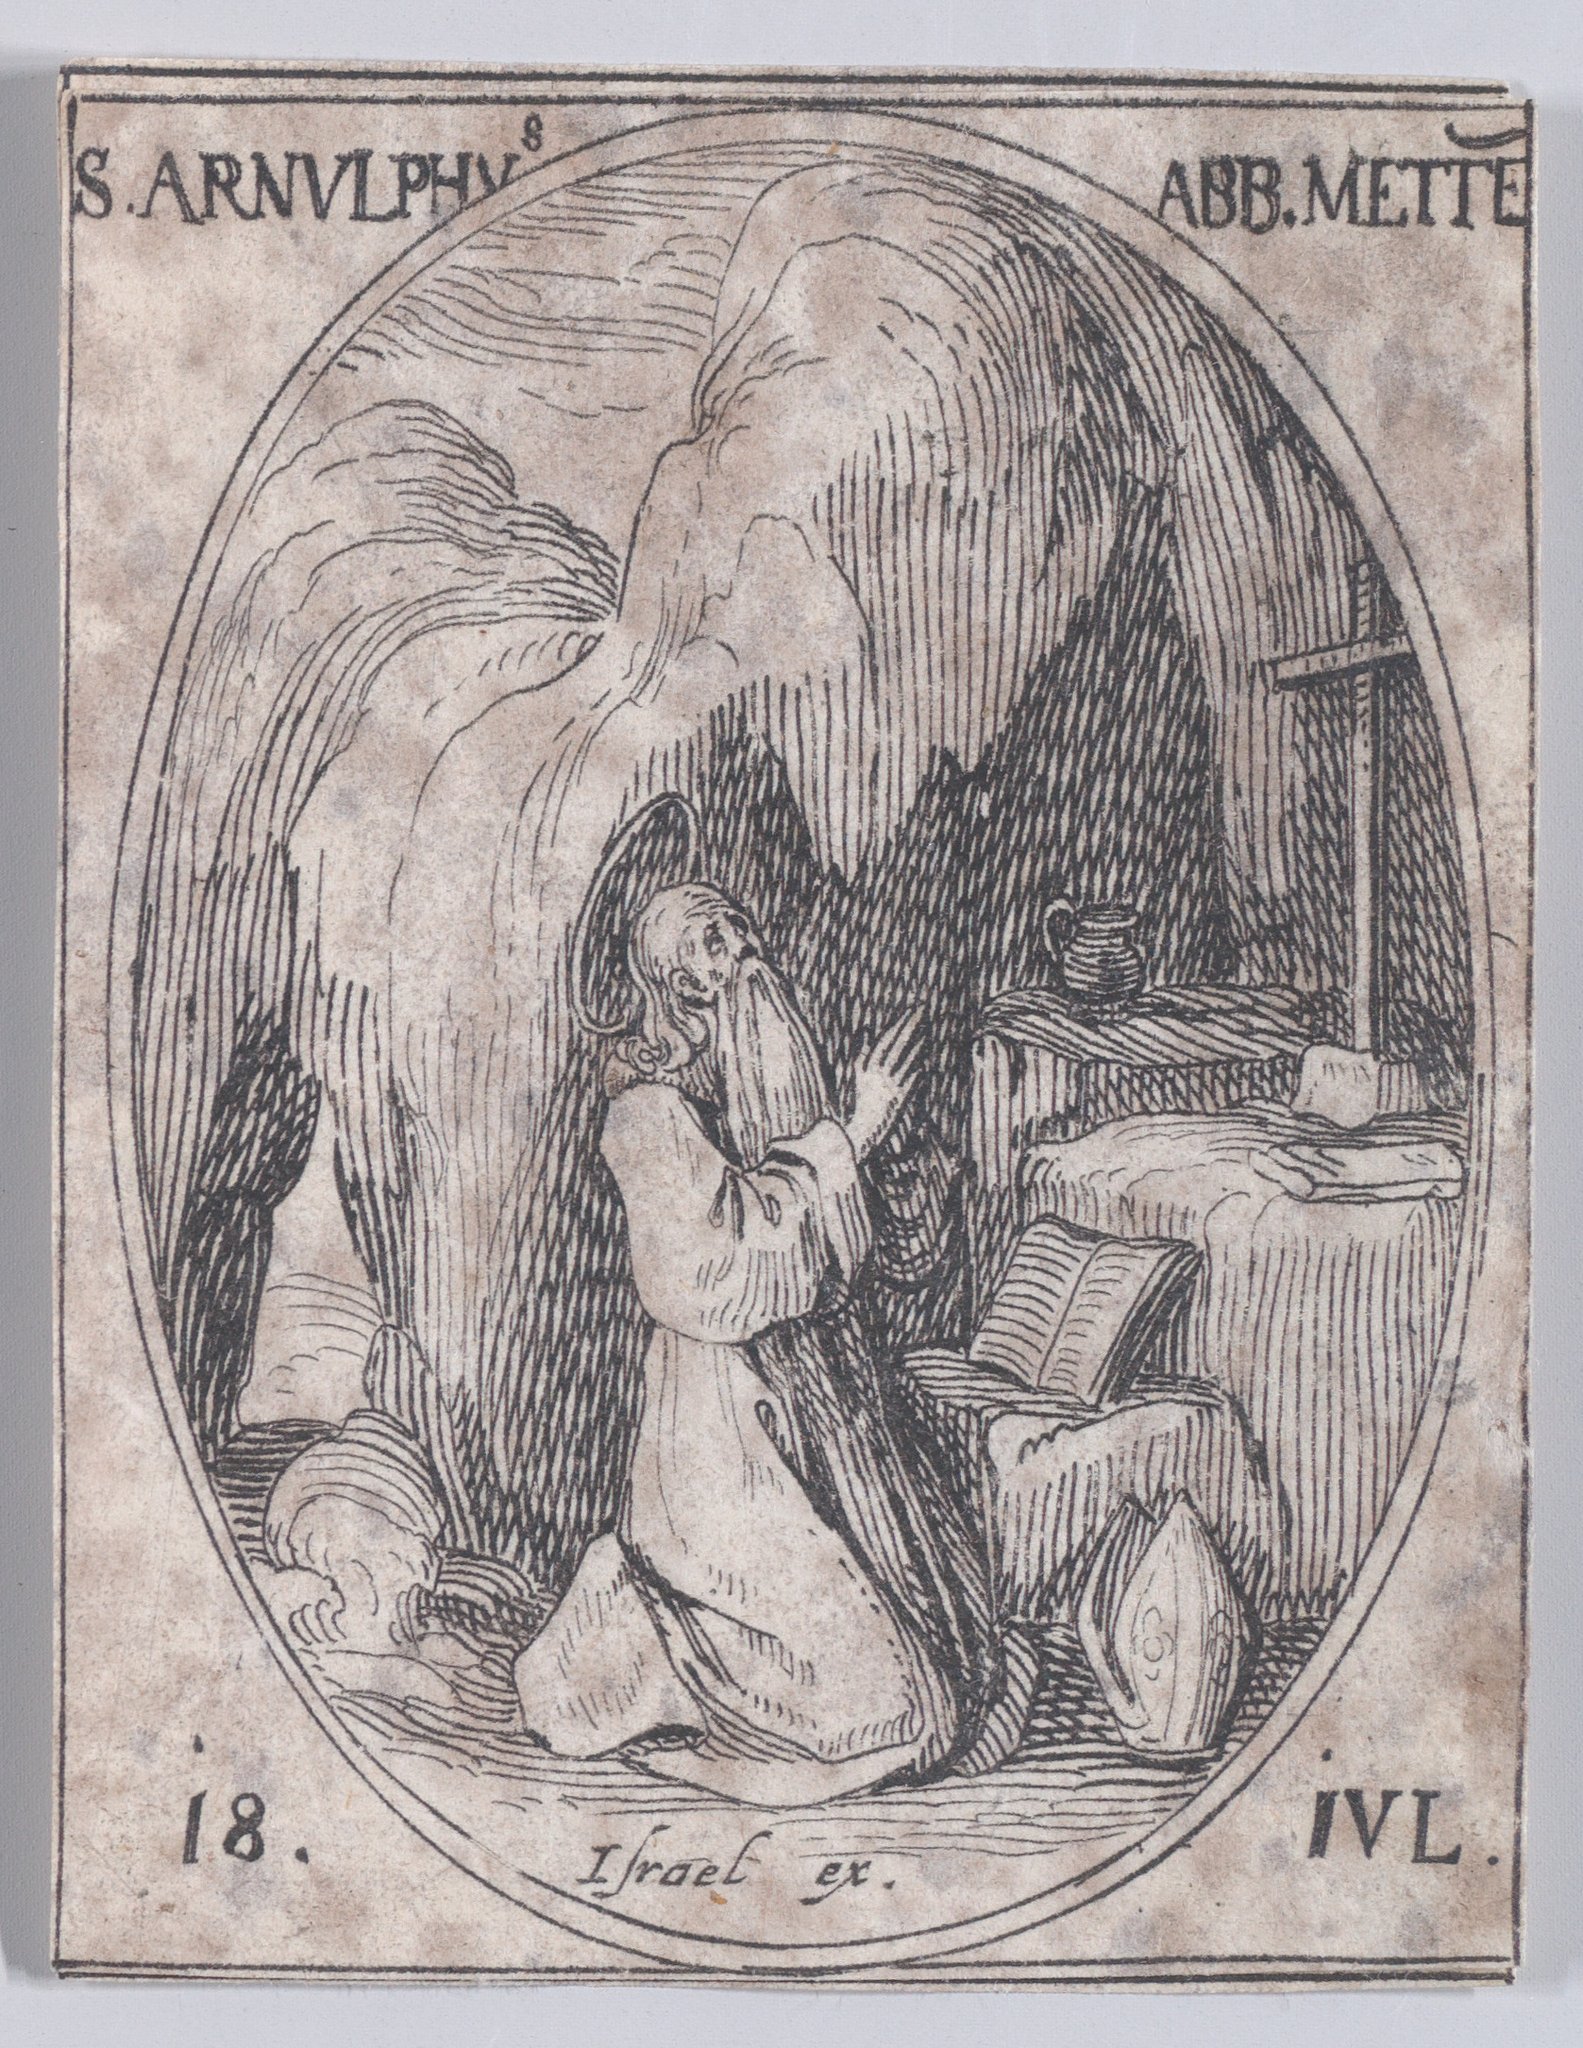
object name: print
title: S. Arnould, évêque de Metz (St. Arnulf, Bishop of Metz), July 18th, from "Les Images De Tous Les Saincts et Saintes de L'Année" (Images of All of the Saints and Religious Events of the Year)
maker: jacques callot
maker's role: artist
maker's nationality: french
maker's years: 1592-1635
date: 1636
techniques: etching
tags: altars,men,saints